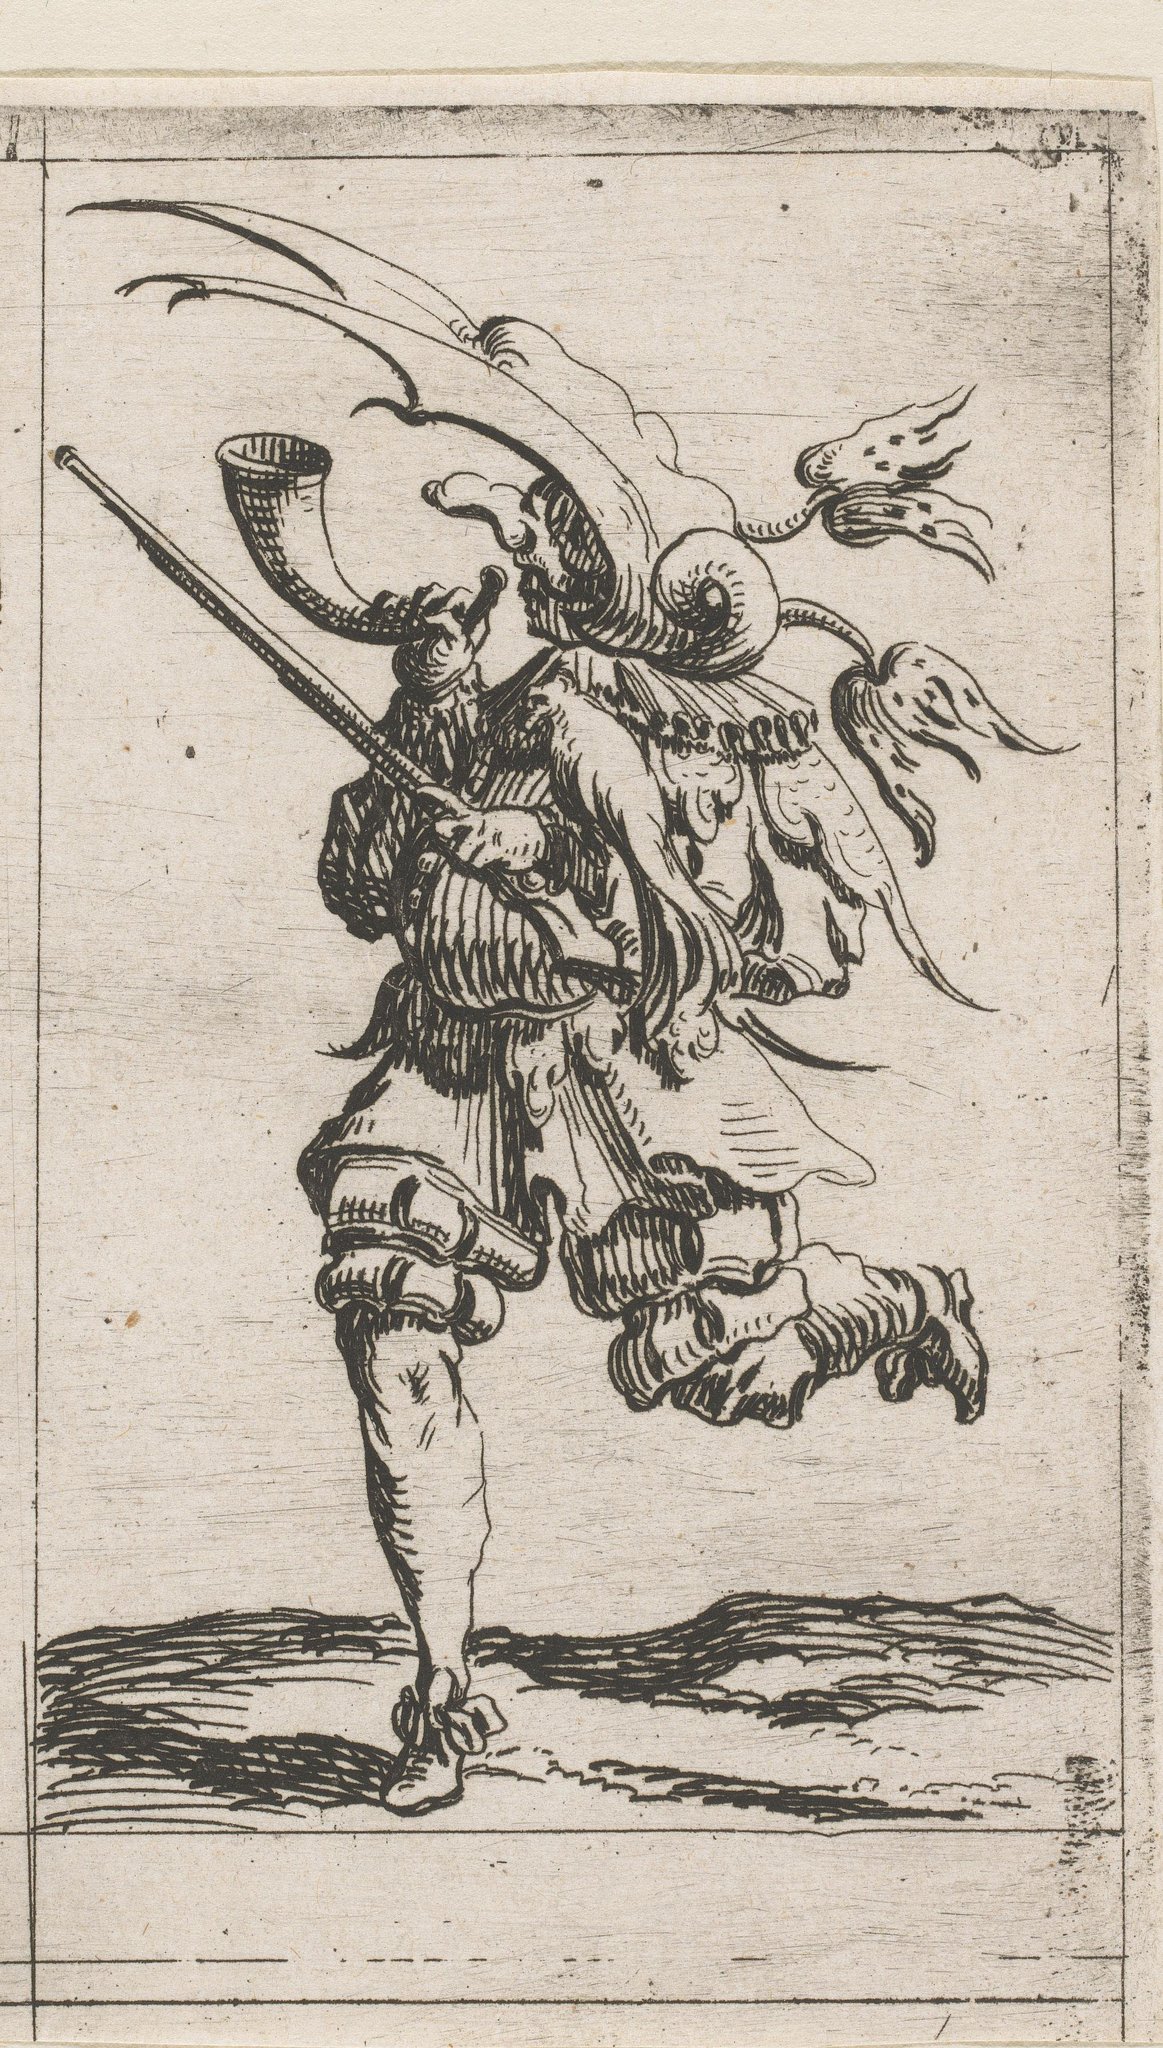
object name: ornament print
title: Twaalf maanden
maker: denis boutemie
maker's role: print maker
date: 1633-1643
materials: paper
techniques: etching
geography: paris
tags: april; 'aprile' (ripa)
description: Personificatie van de maand april. Een grotesk figuur met een hoed met twee tulpen op zijn hoofd. Hij danst met een hoorn en een geweer in zijn handen.